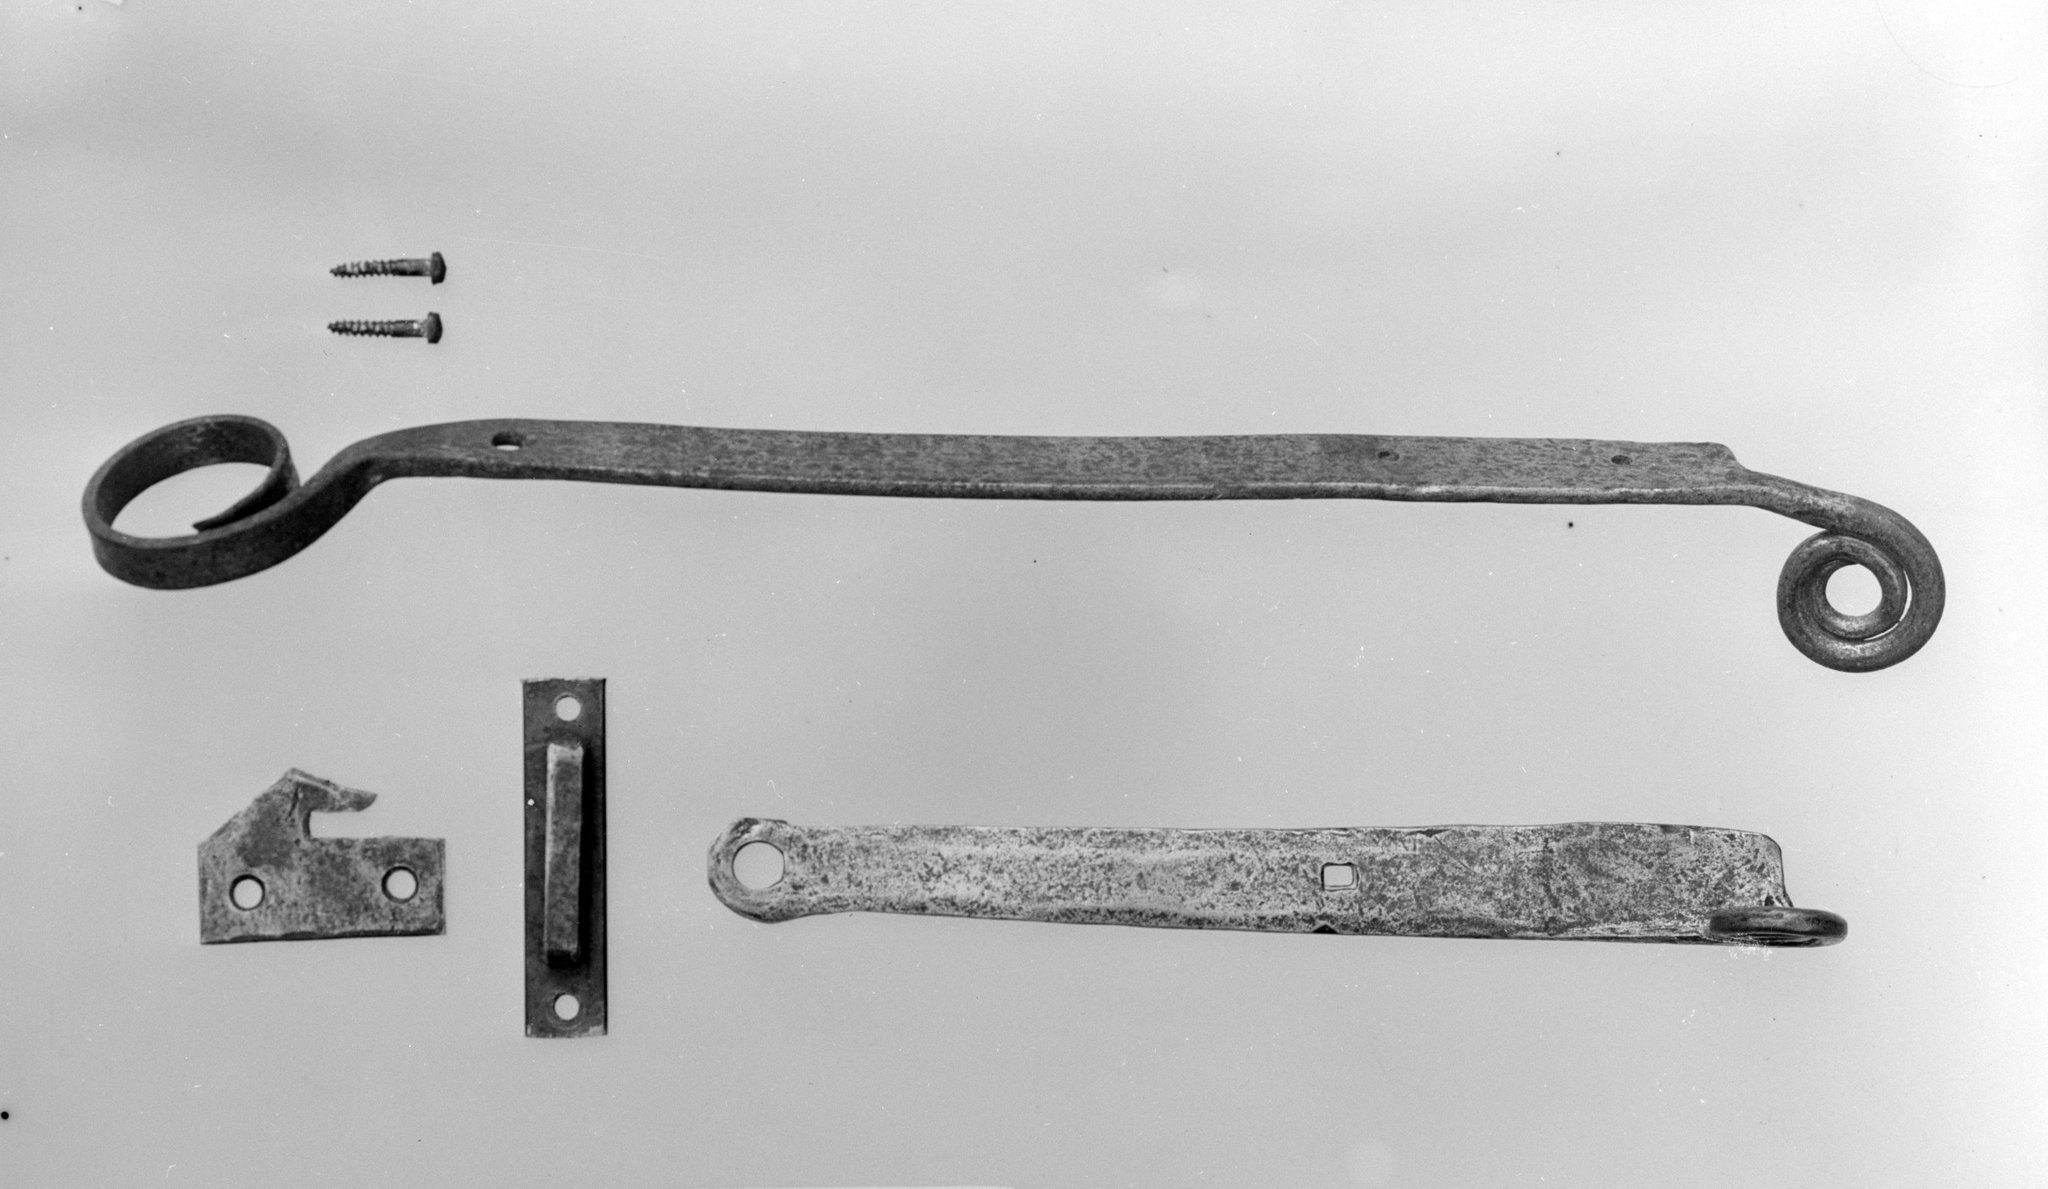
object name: latch bar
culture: american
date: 1700-1800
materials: iron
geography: united states